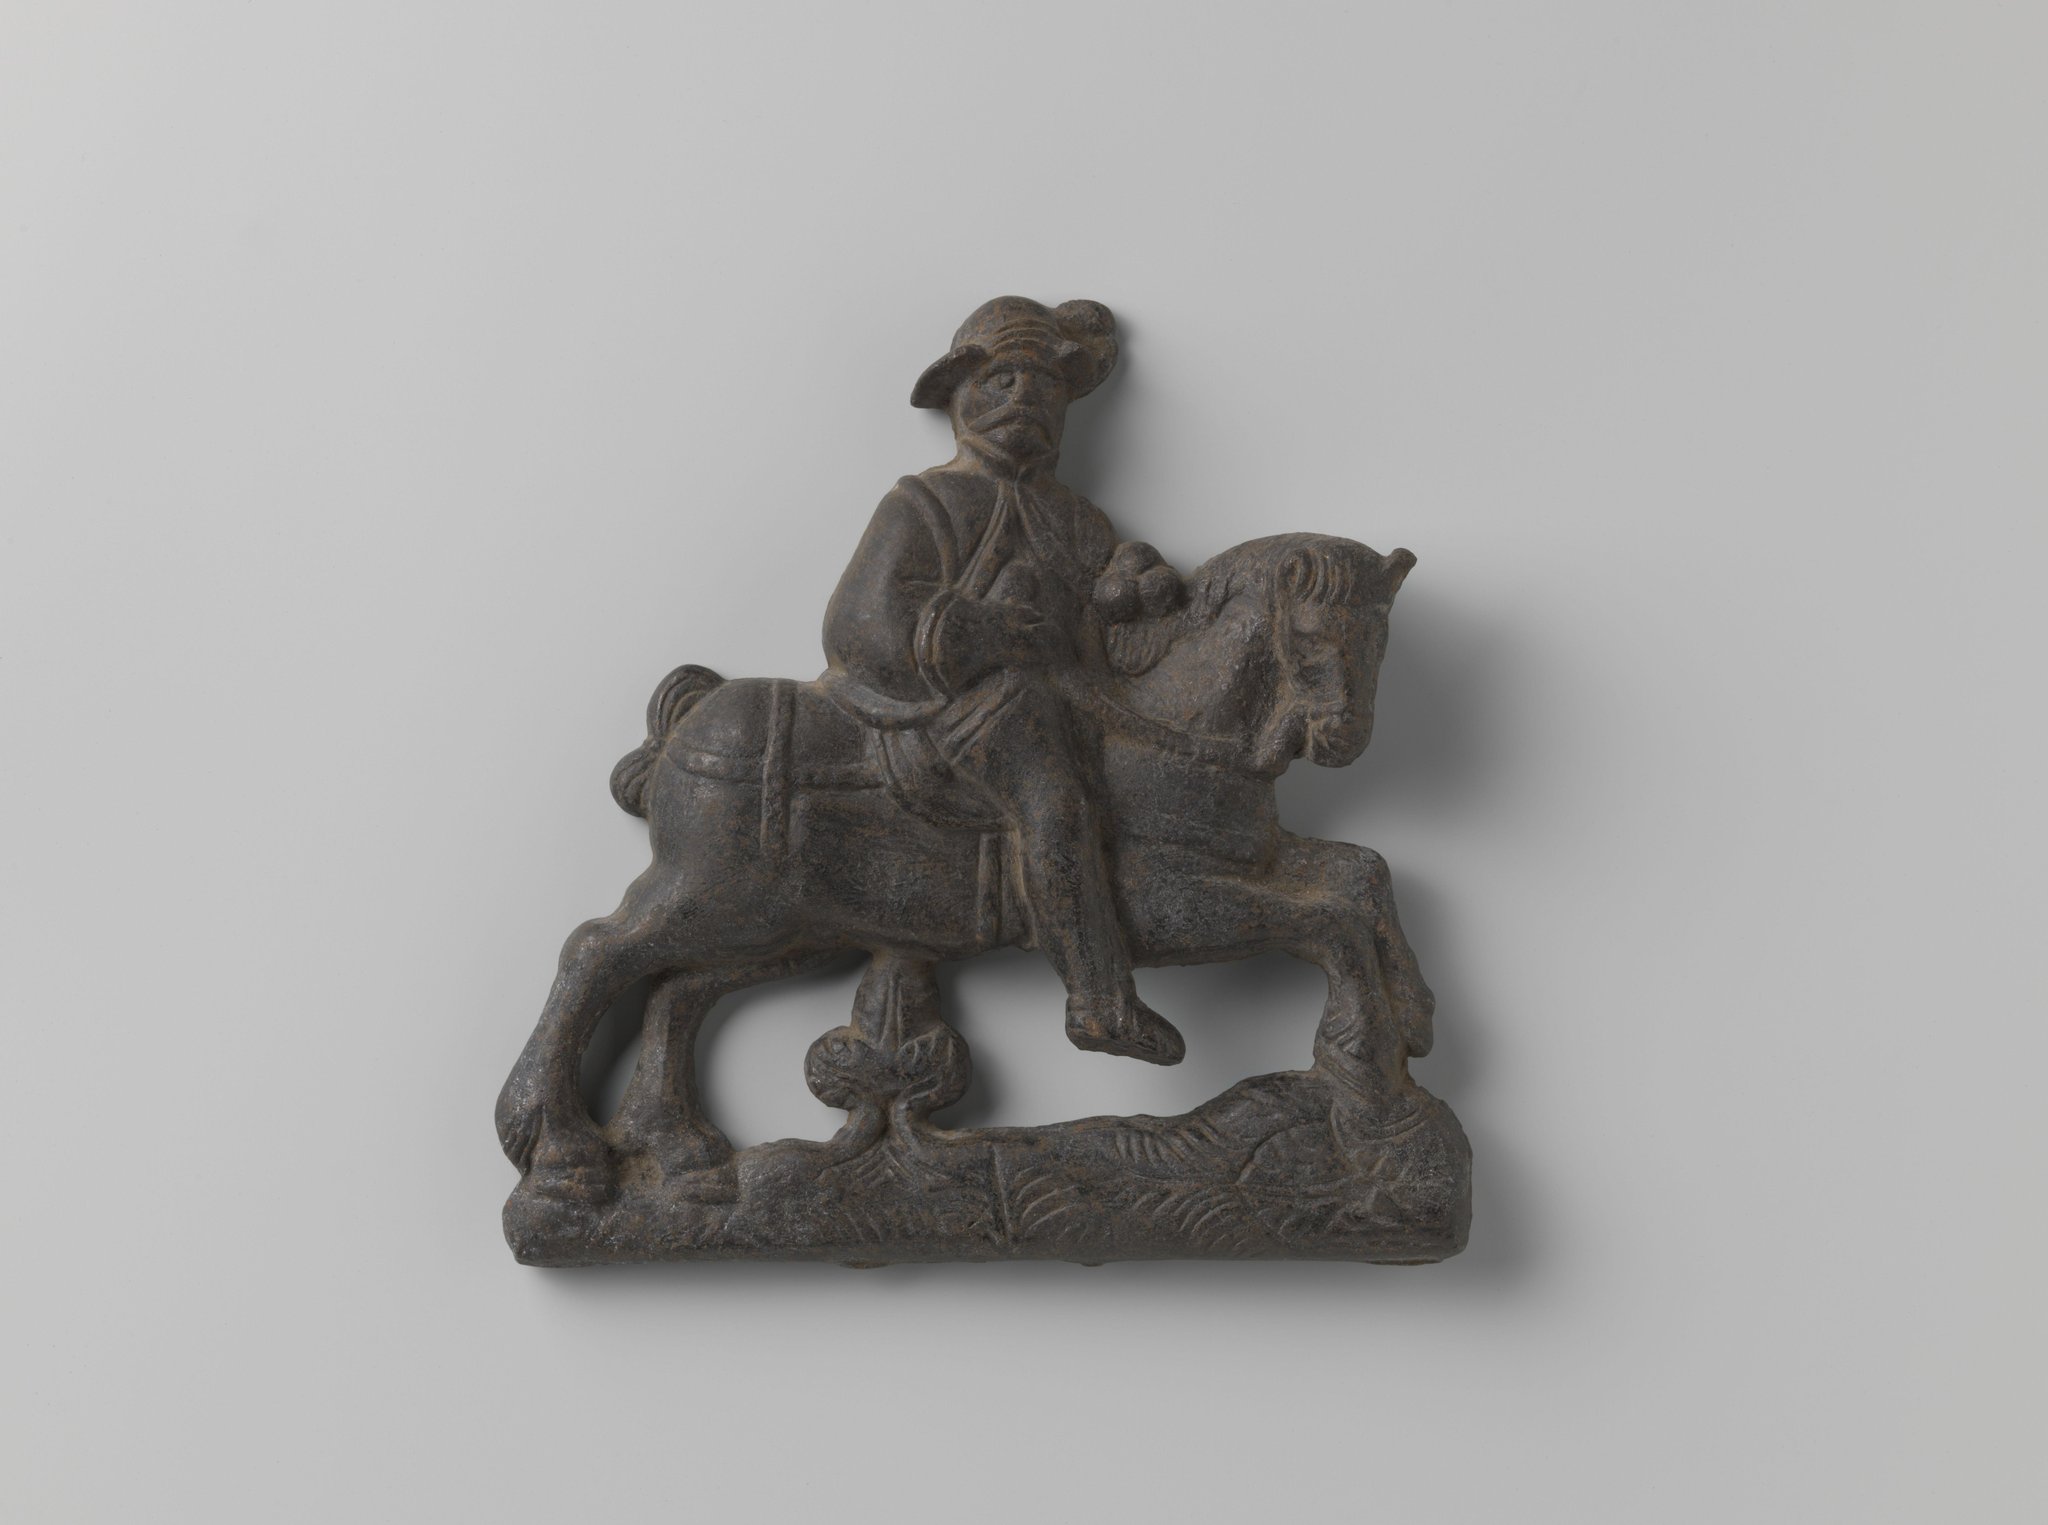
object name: sculpture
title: Basreliëf met afbeelding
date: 1400-1950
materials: iron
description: Basreliëf met afbeelding van een ruiter te paard.